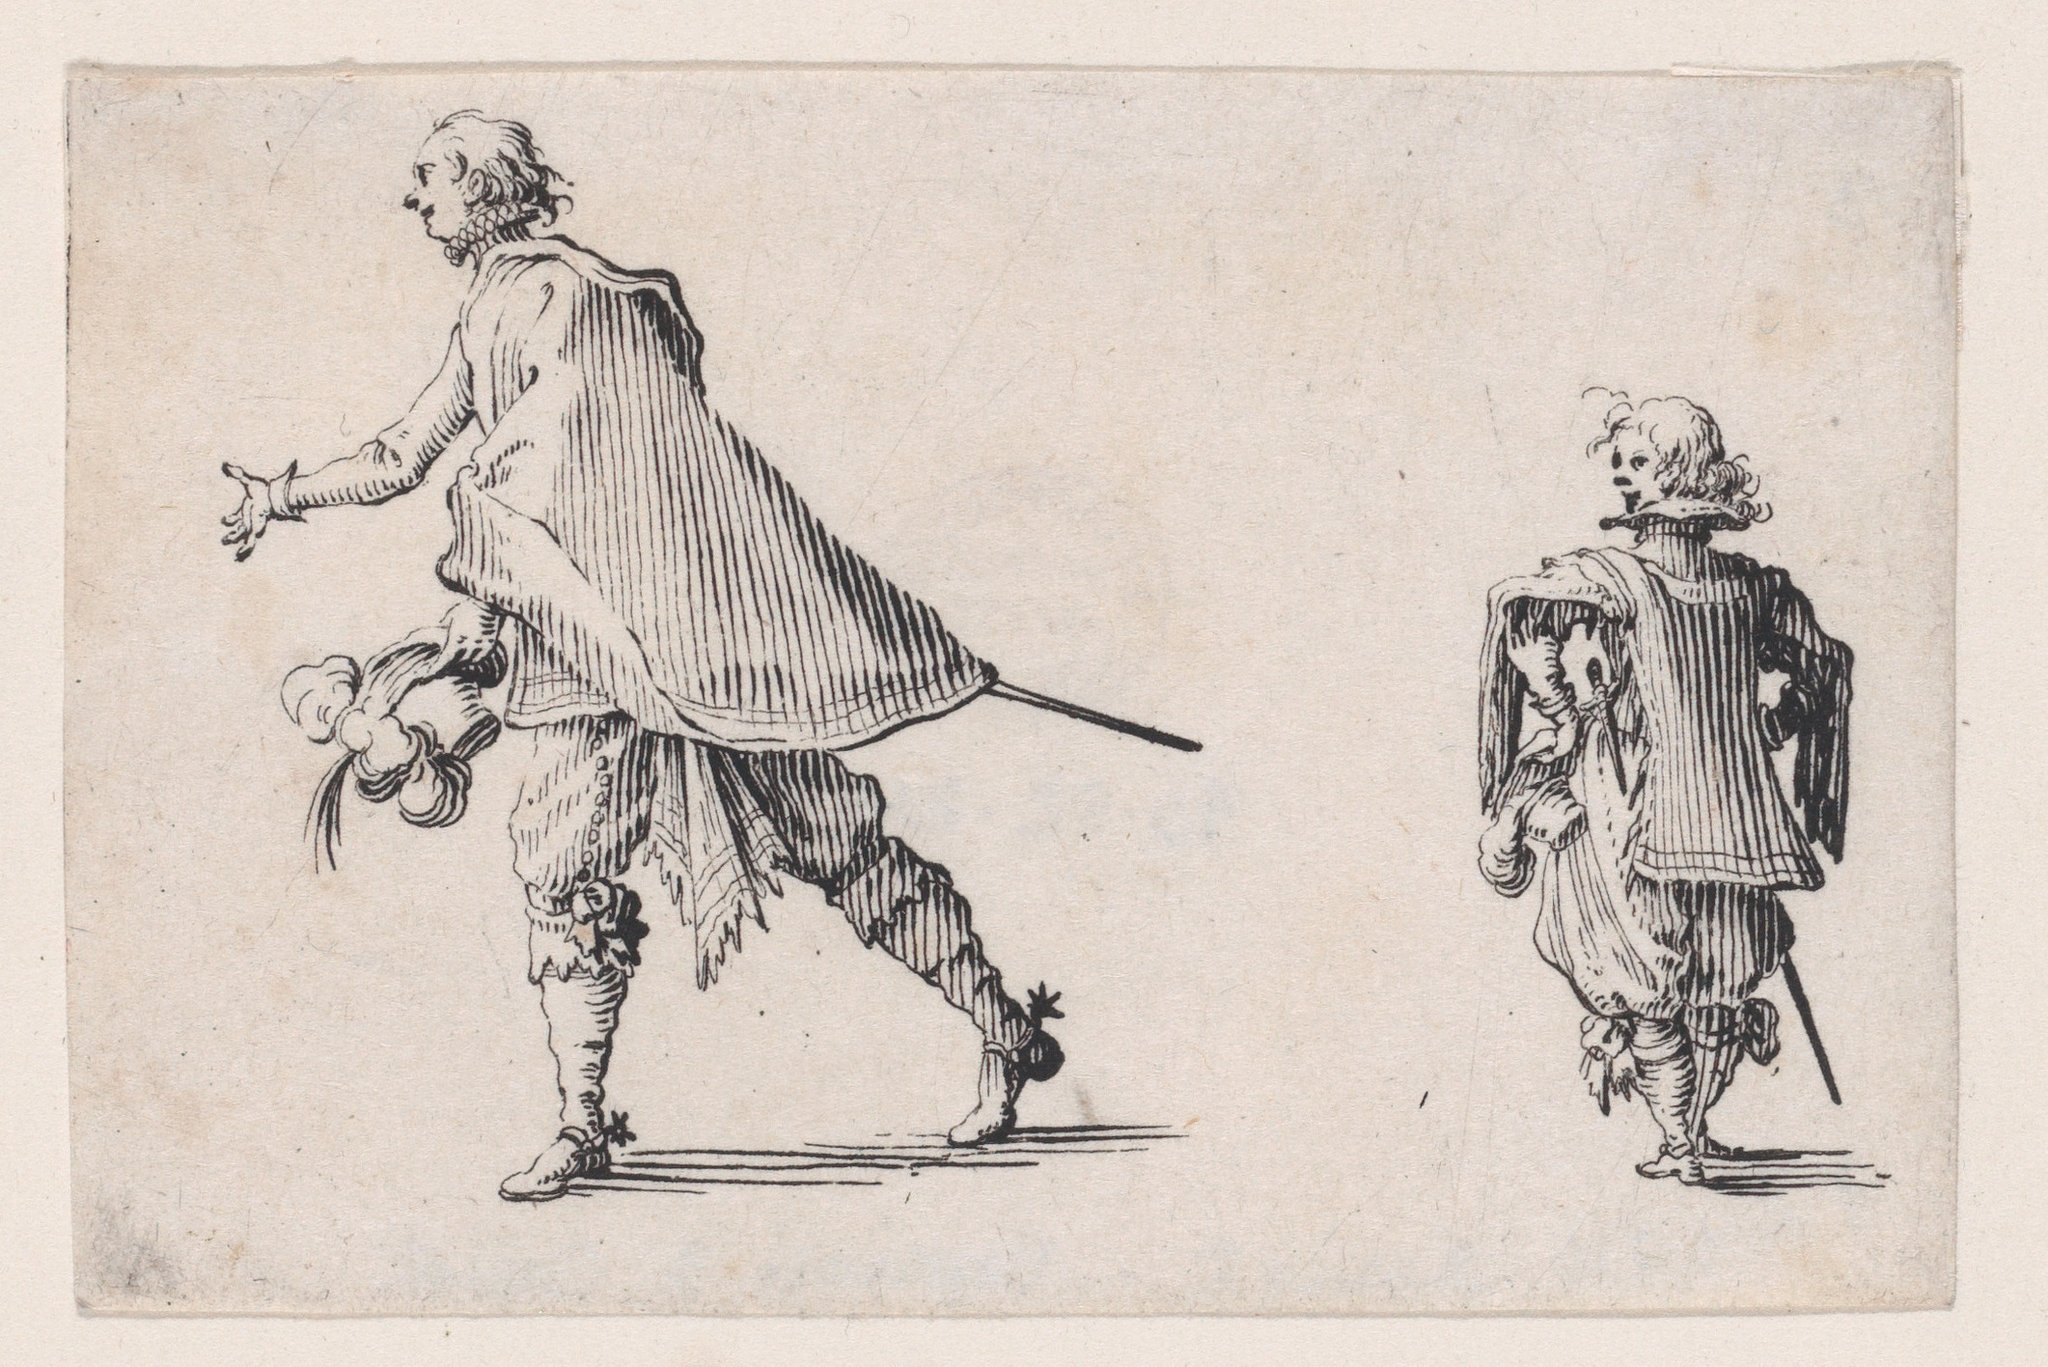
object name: print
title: Un Gentilhomme et son Page (A Gentleman and his Page), from "Les Caprices" Series A, The Florence Set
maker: jacques callot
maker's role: artist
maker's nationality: french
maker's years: 1592-1635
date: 1617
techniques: etching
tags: boys,men